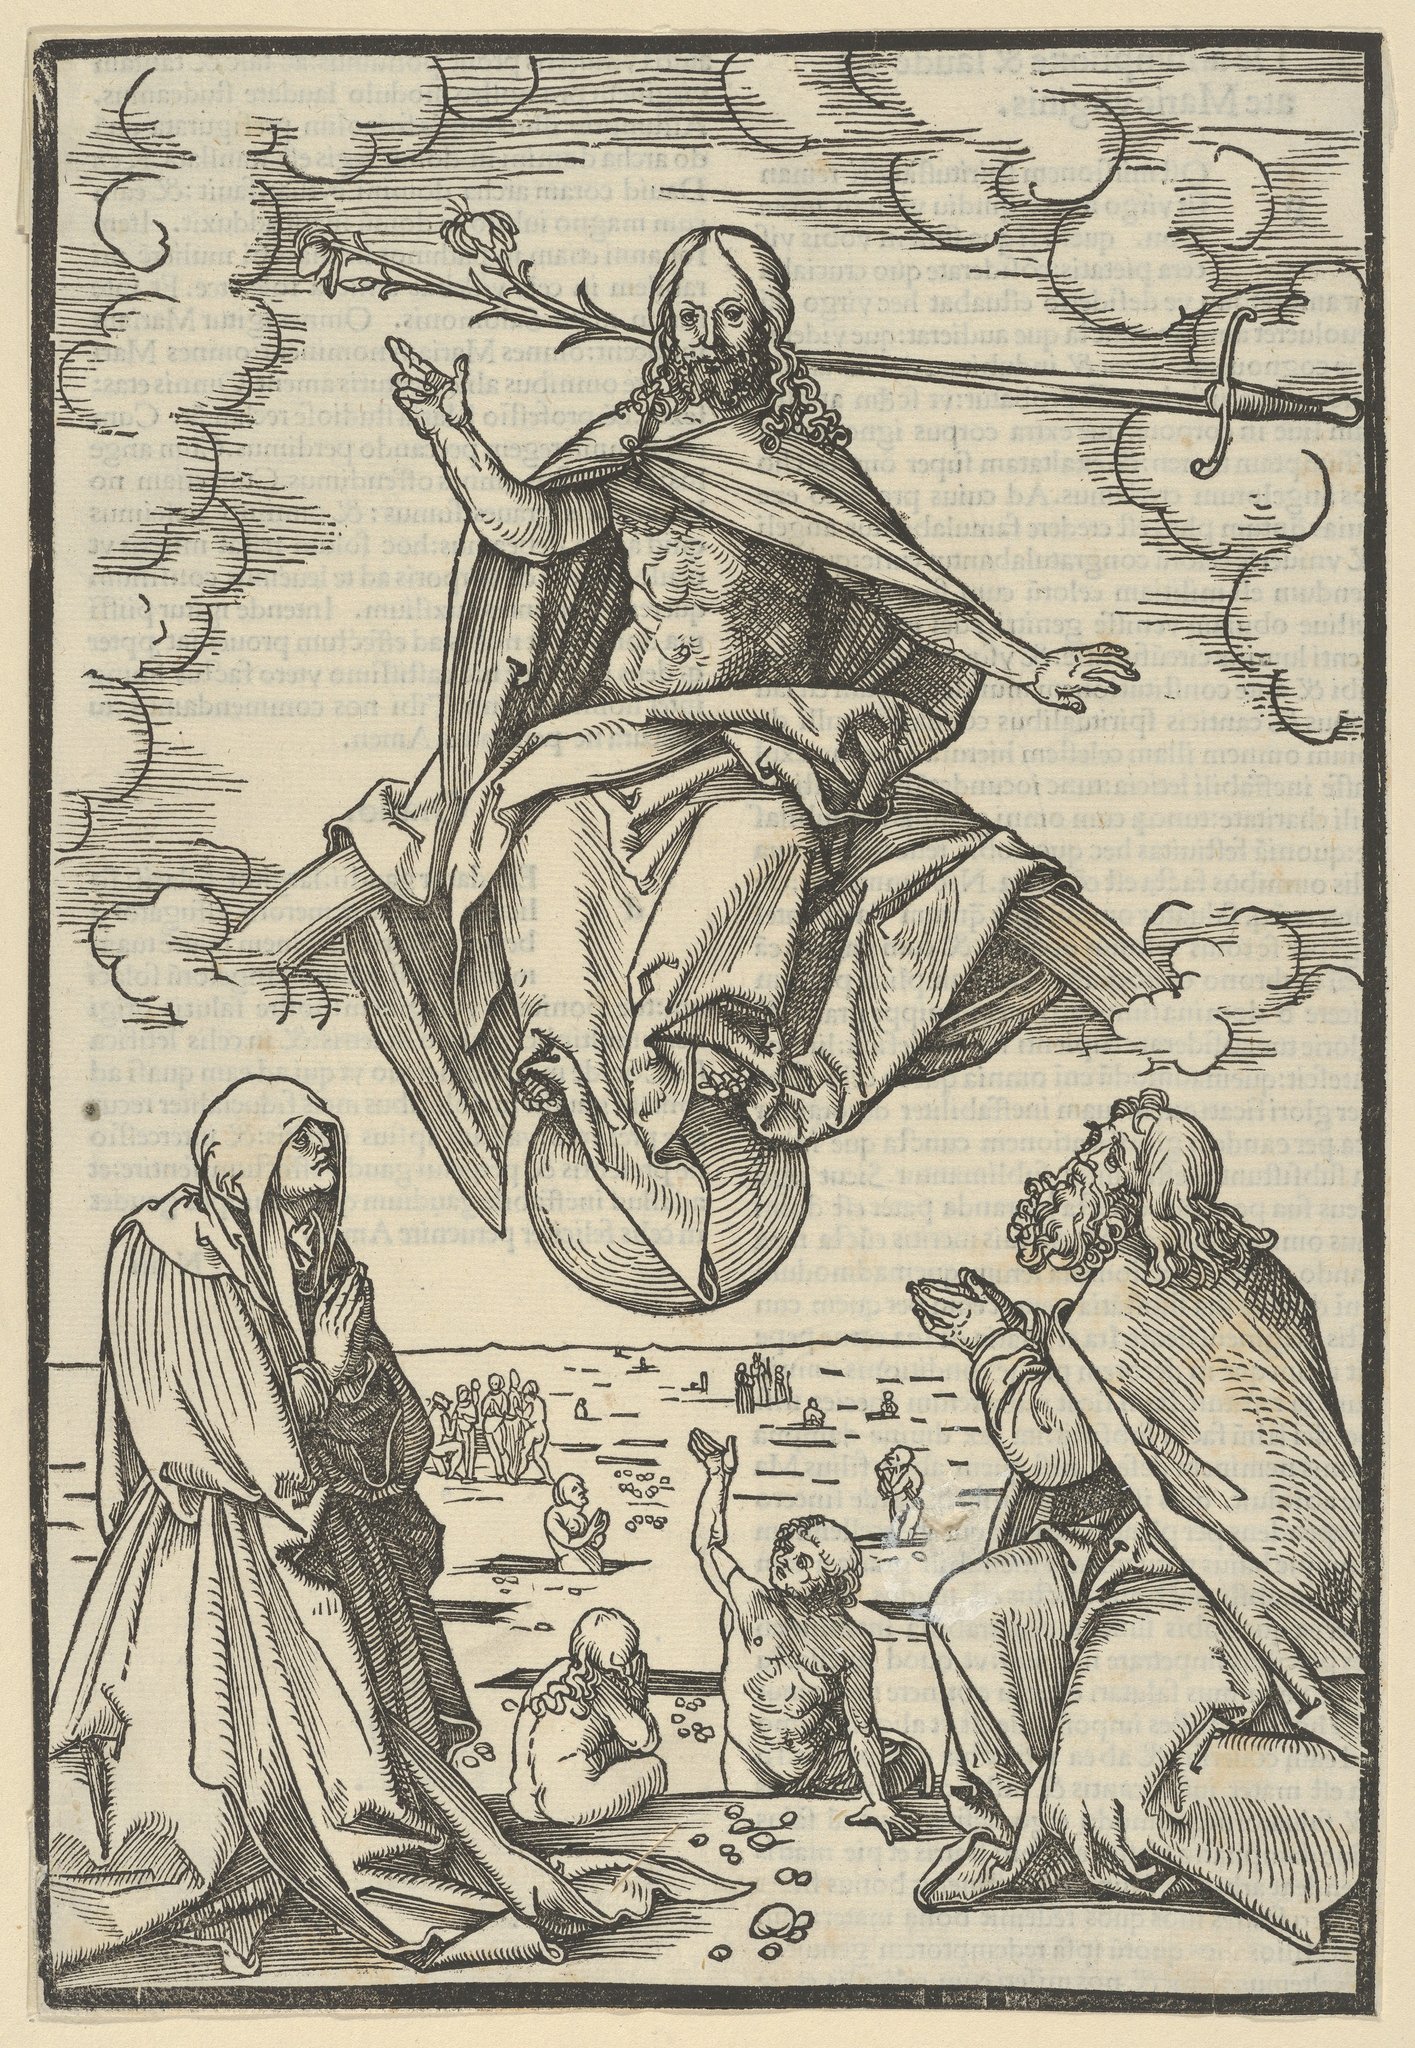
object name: print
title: The Last Judgment, from Speculum passionis domini nostri Ihesu Christi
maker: hans schäufelein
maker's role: artist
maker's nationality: german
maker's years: 1480-1540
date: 1507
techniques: woodcut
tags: suffering,christ,last judgement